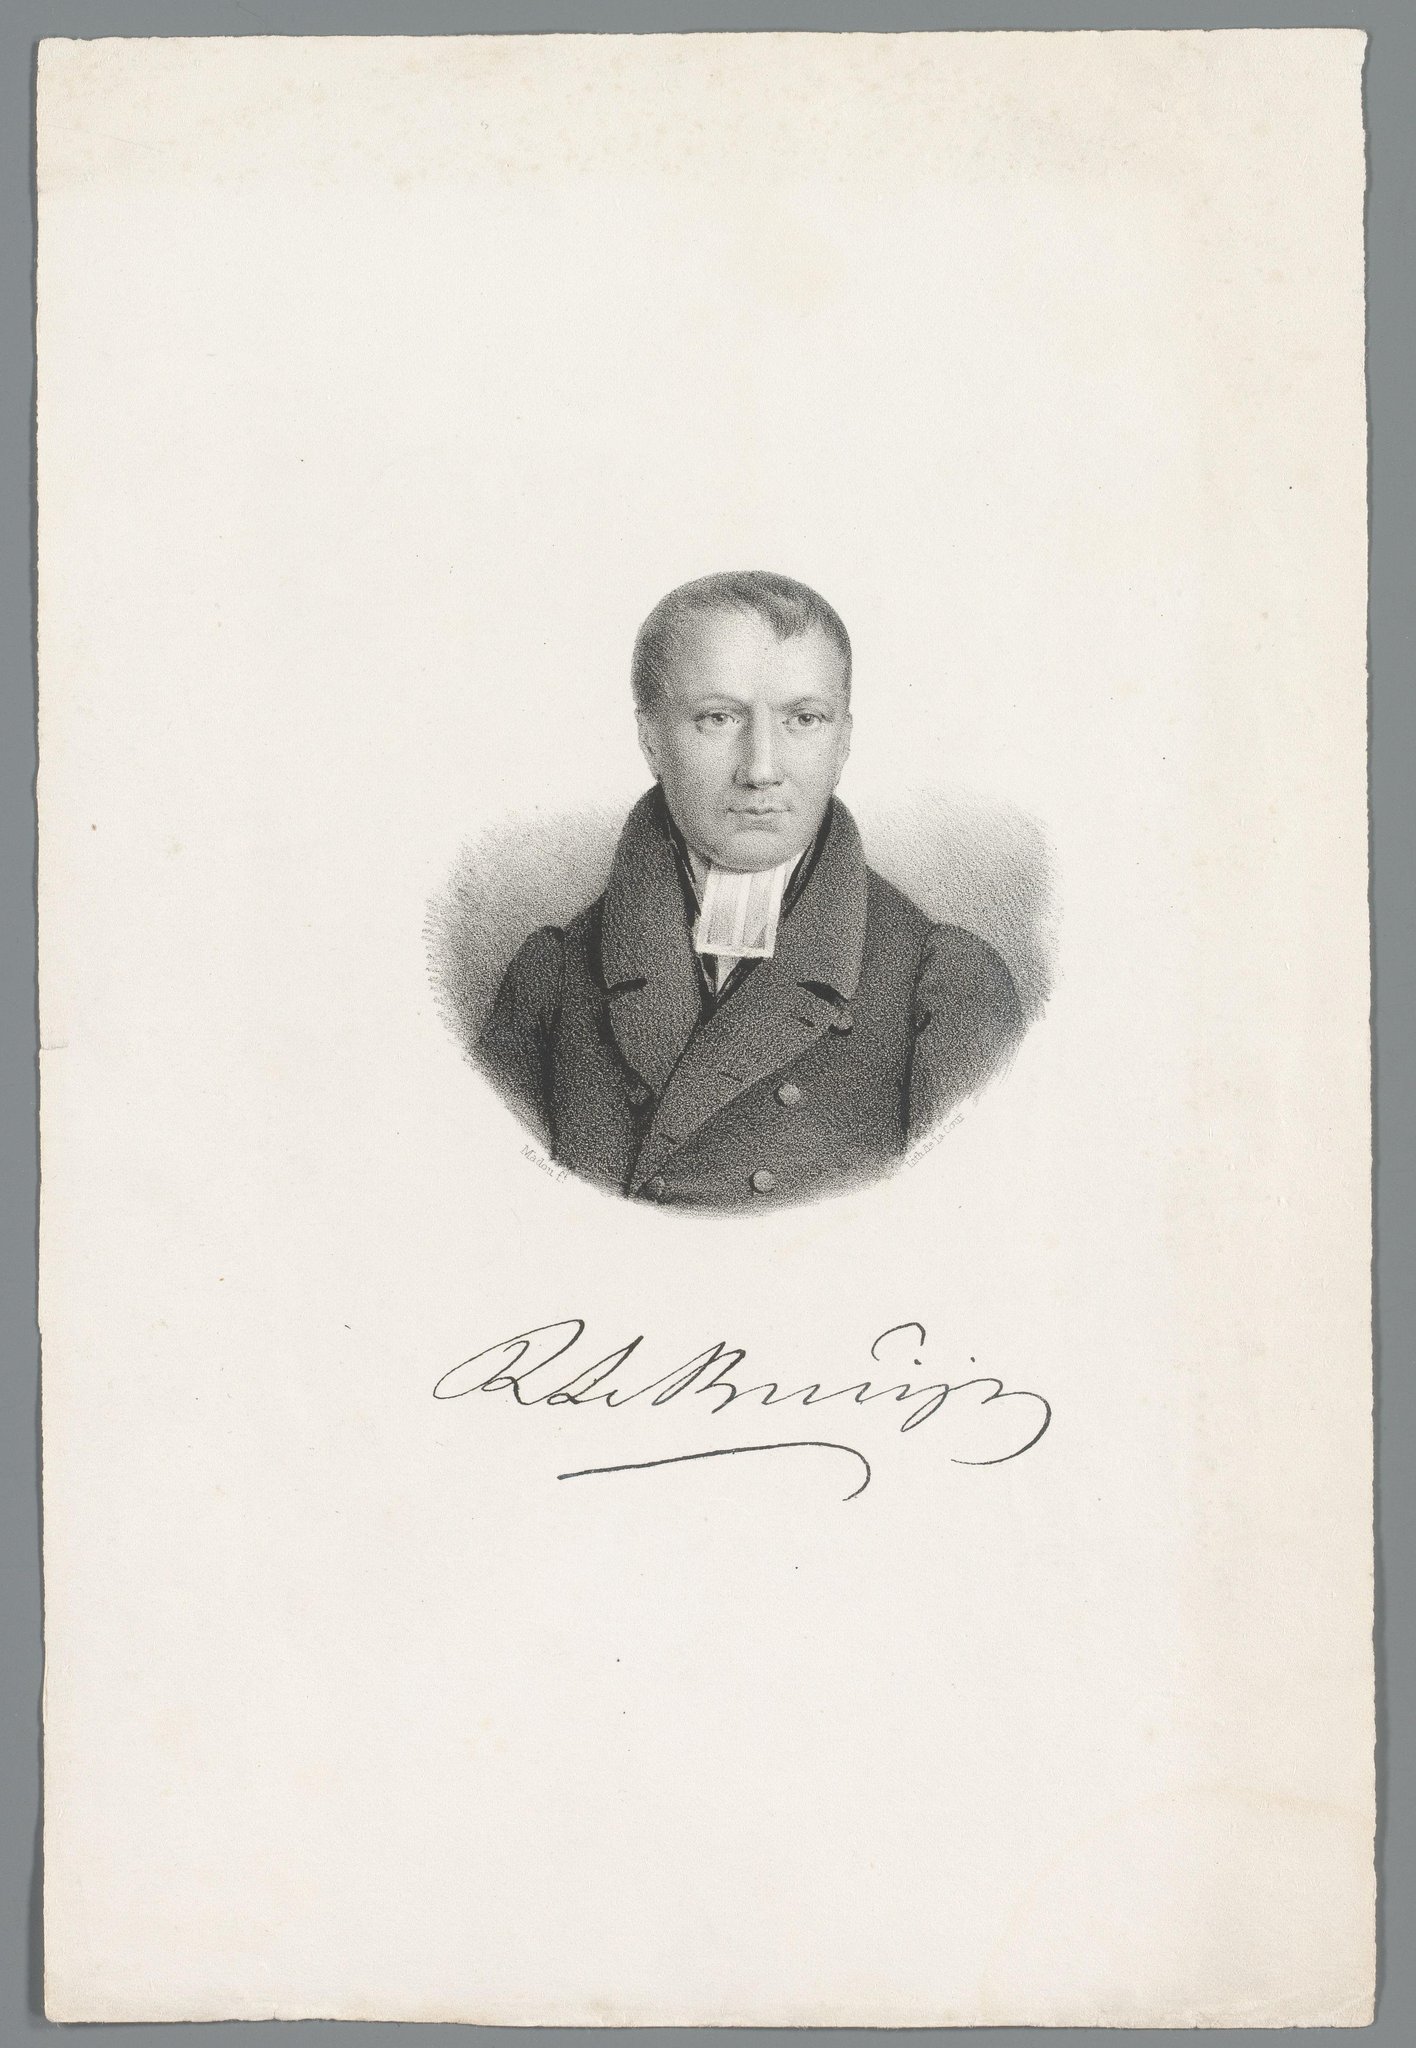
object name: print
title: Portret van Reynt le Bruijn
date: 1827-1851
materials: paper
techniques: lithograph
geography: brussels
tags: historical persons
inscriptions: collector's mark: Lugt 2233